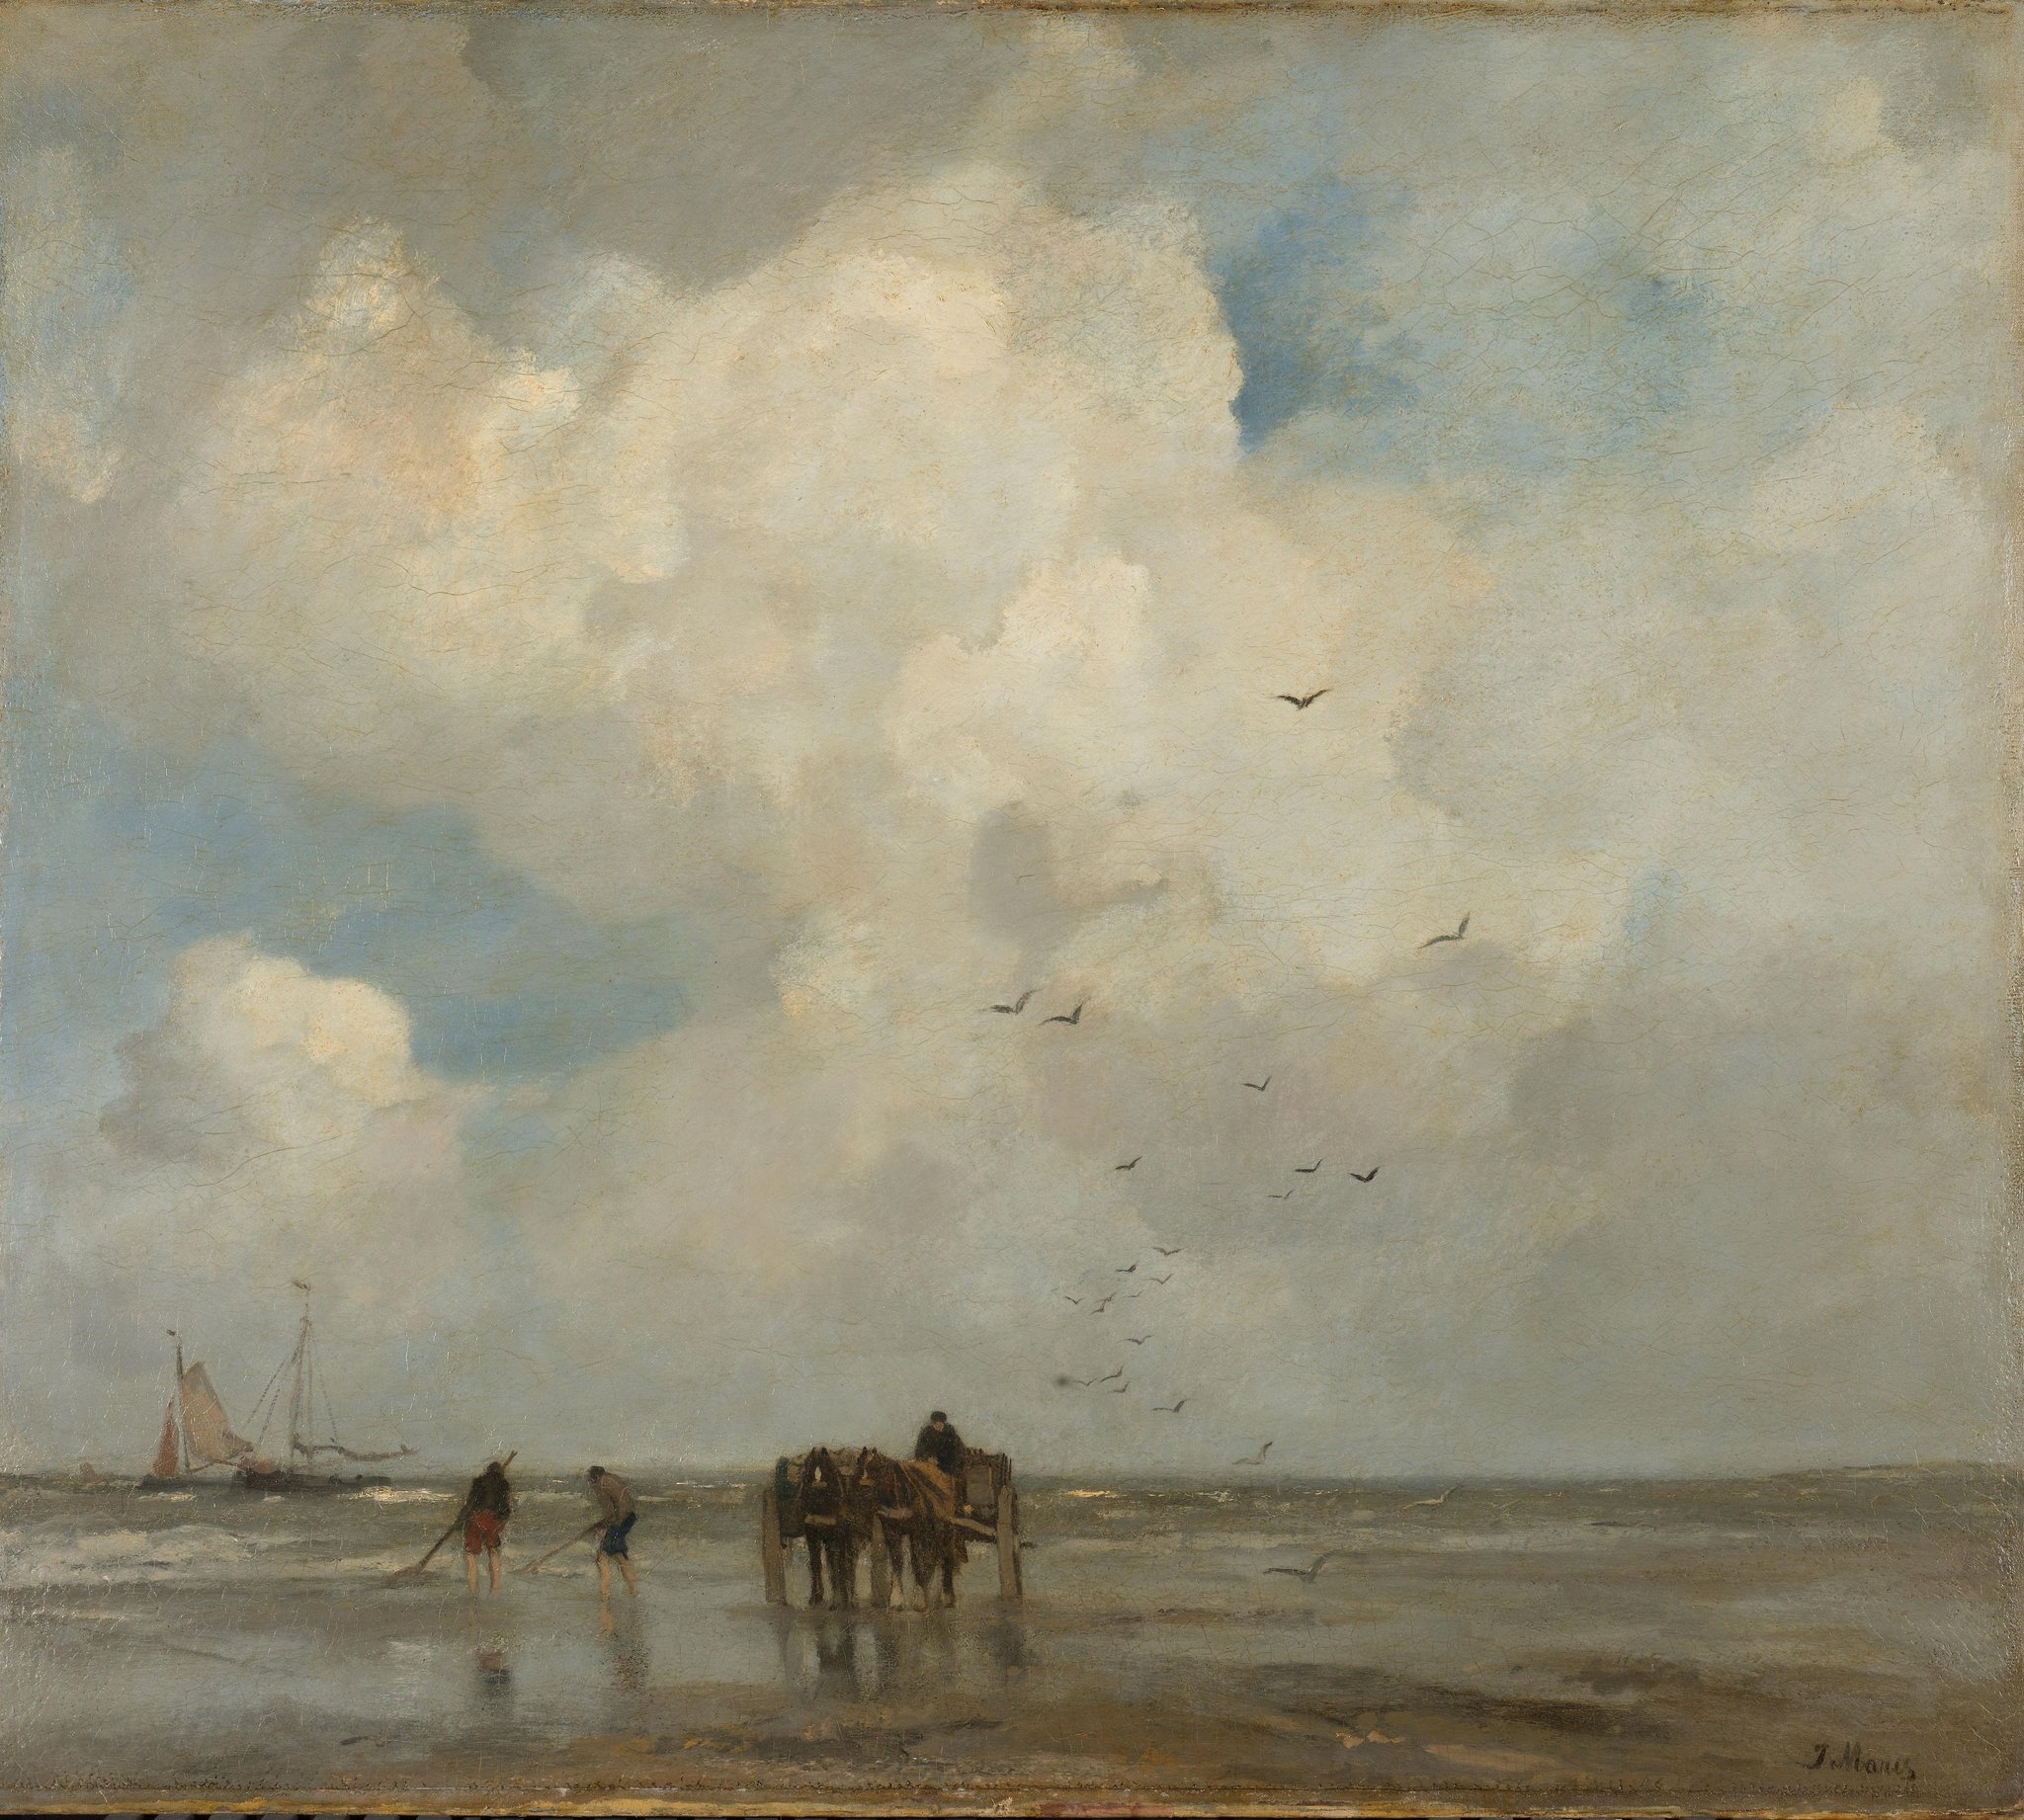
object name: painting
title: Fishing for Shells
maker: jacob maris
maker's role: draughtsman, painter, print maker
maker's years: 1837-1899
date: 1885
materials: canvas, oil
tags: shell fishery, beach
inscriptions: signature: ‘J. Maris’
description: Fishermen comb the shoreline with their nets in search of shells, their diminutive figures dwarfed by the expansive beach around them. However, the true star of the composition is the broadly painted sky. Maris used a host of grey and white shades to capture the silvery light of a day by the sea. He was fascinated by the pristine Dutch coastal landscape, which was gradually changing with the advent of tourism.